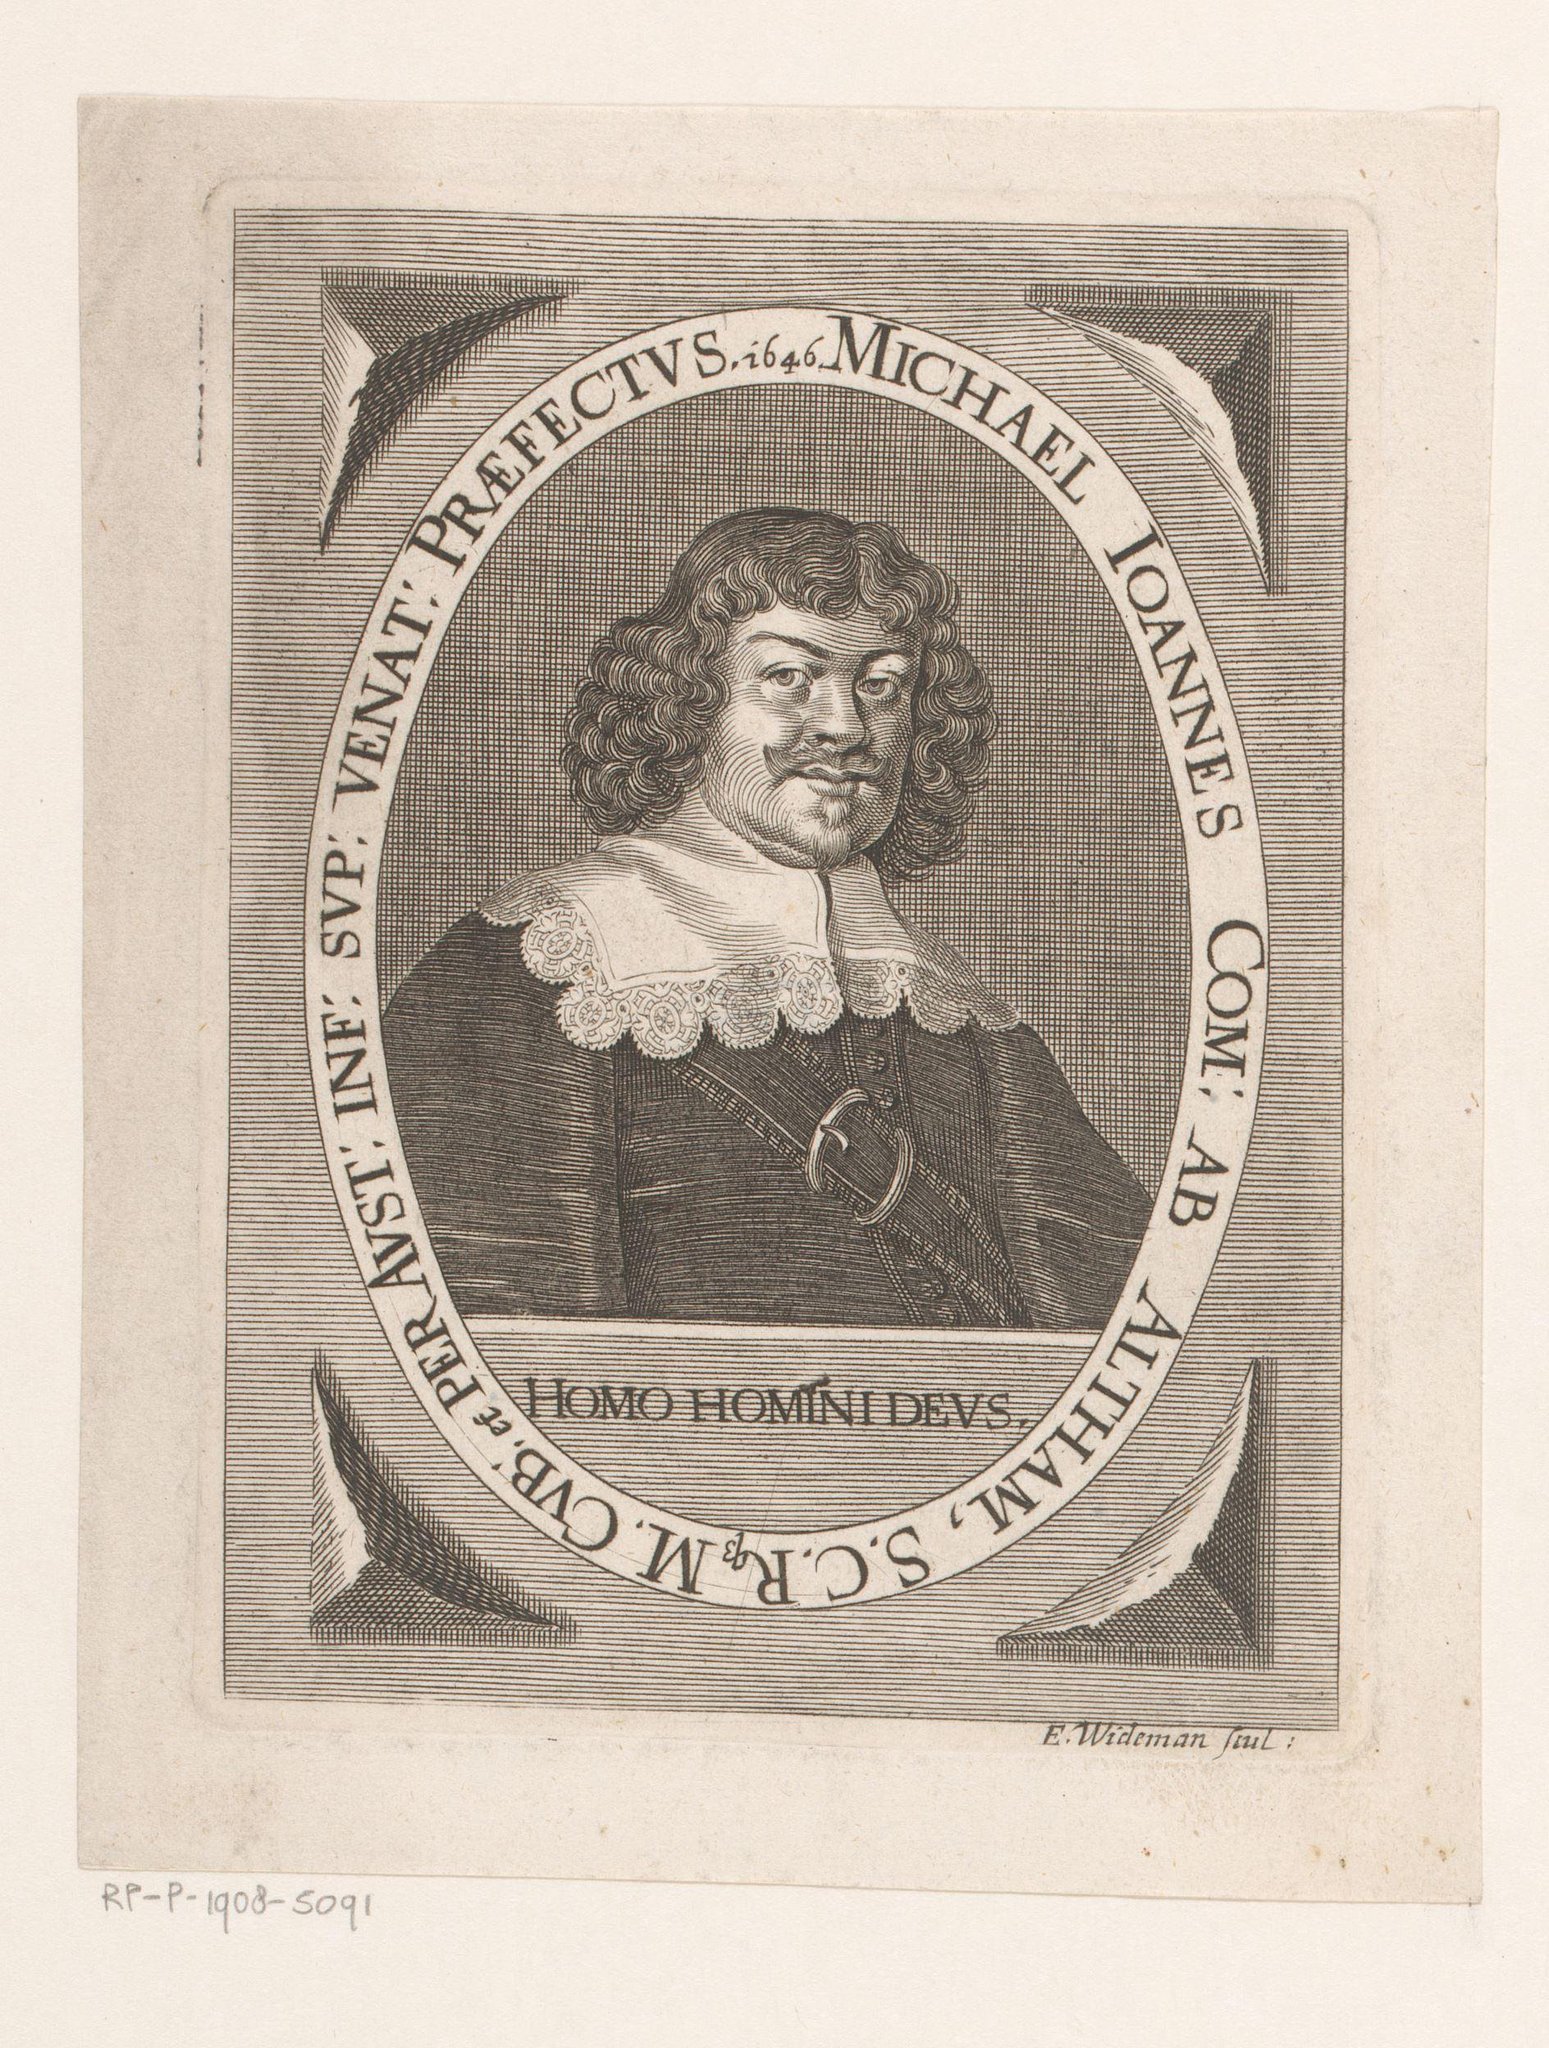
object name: print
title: Portret van Michael Ioannes von Altham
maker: elias widemann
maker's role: print maker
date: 1646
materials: paper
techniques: engraving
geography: germany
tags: historical persons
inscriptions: collector's mark: Lugt 2228